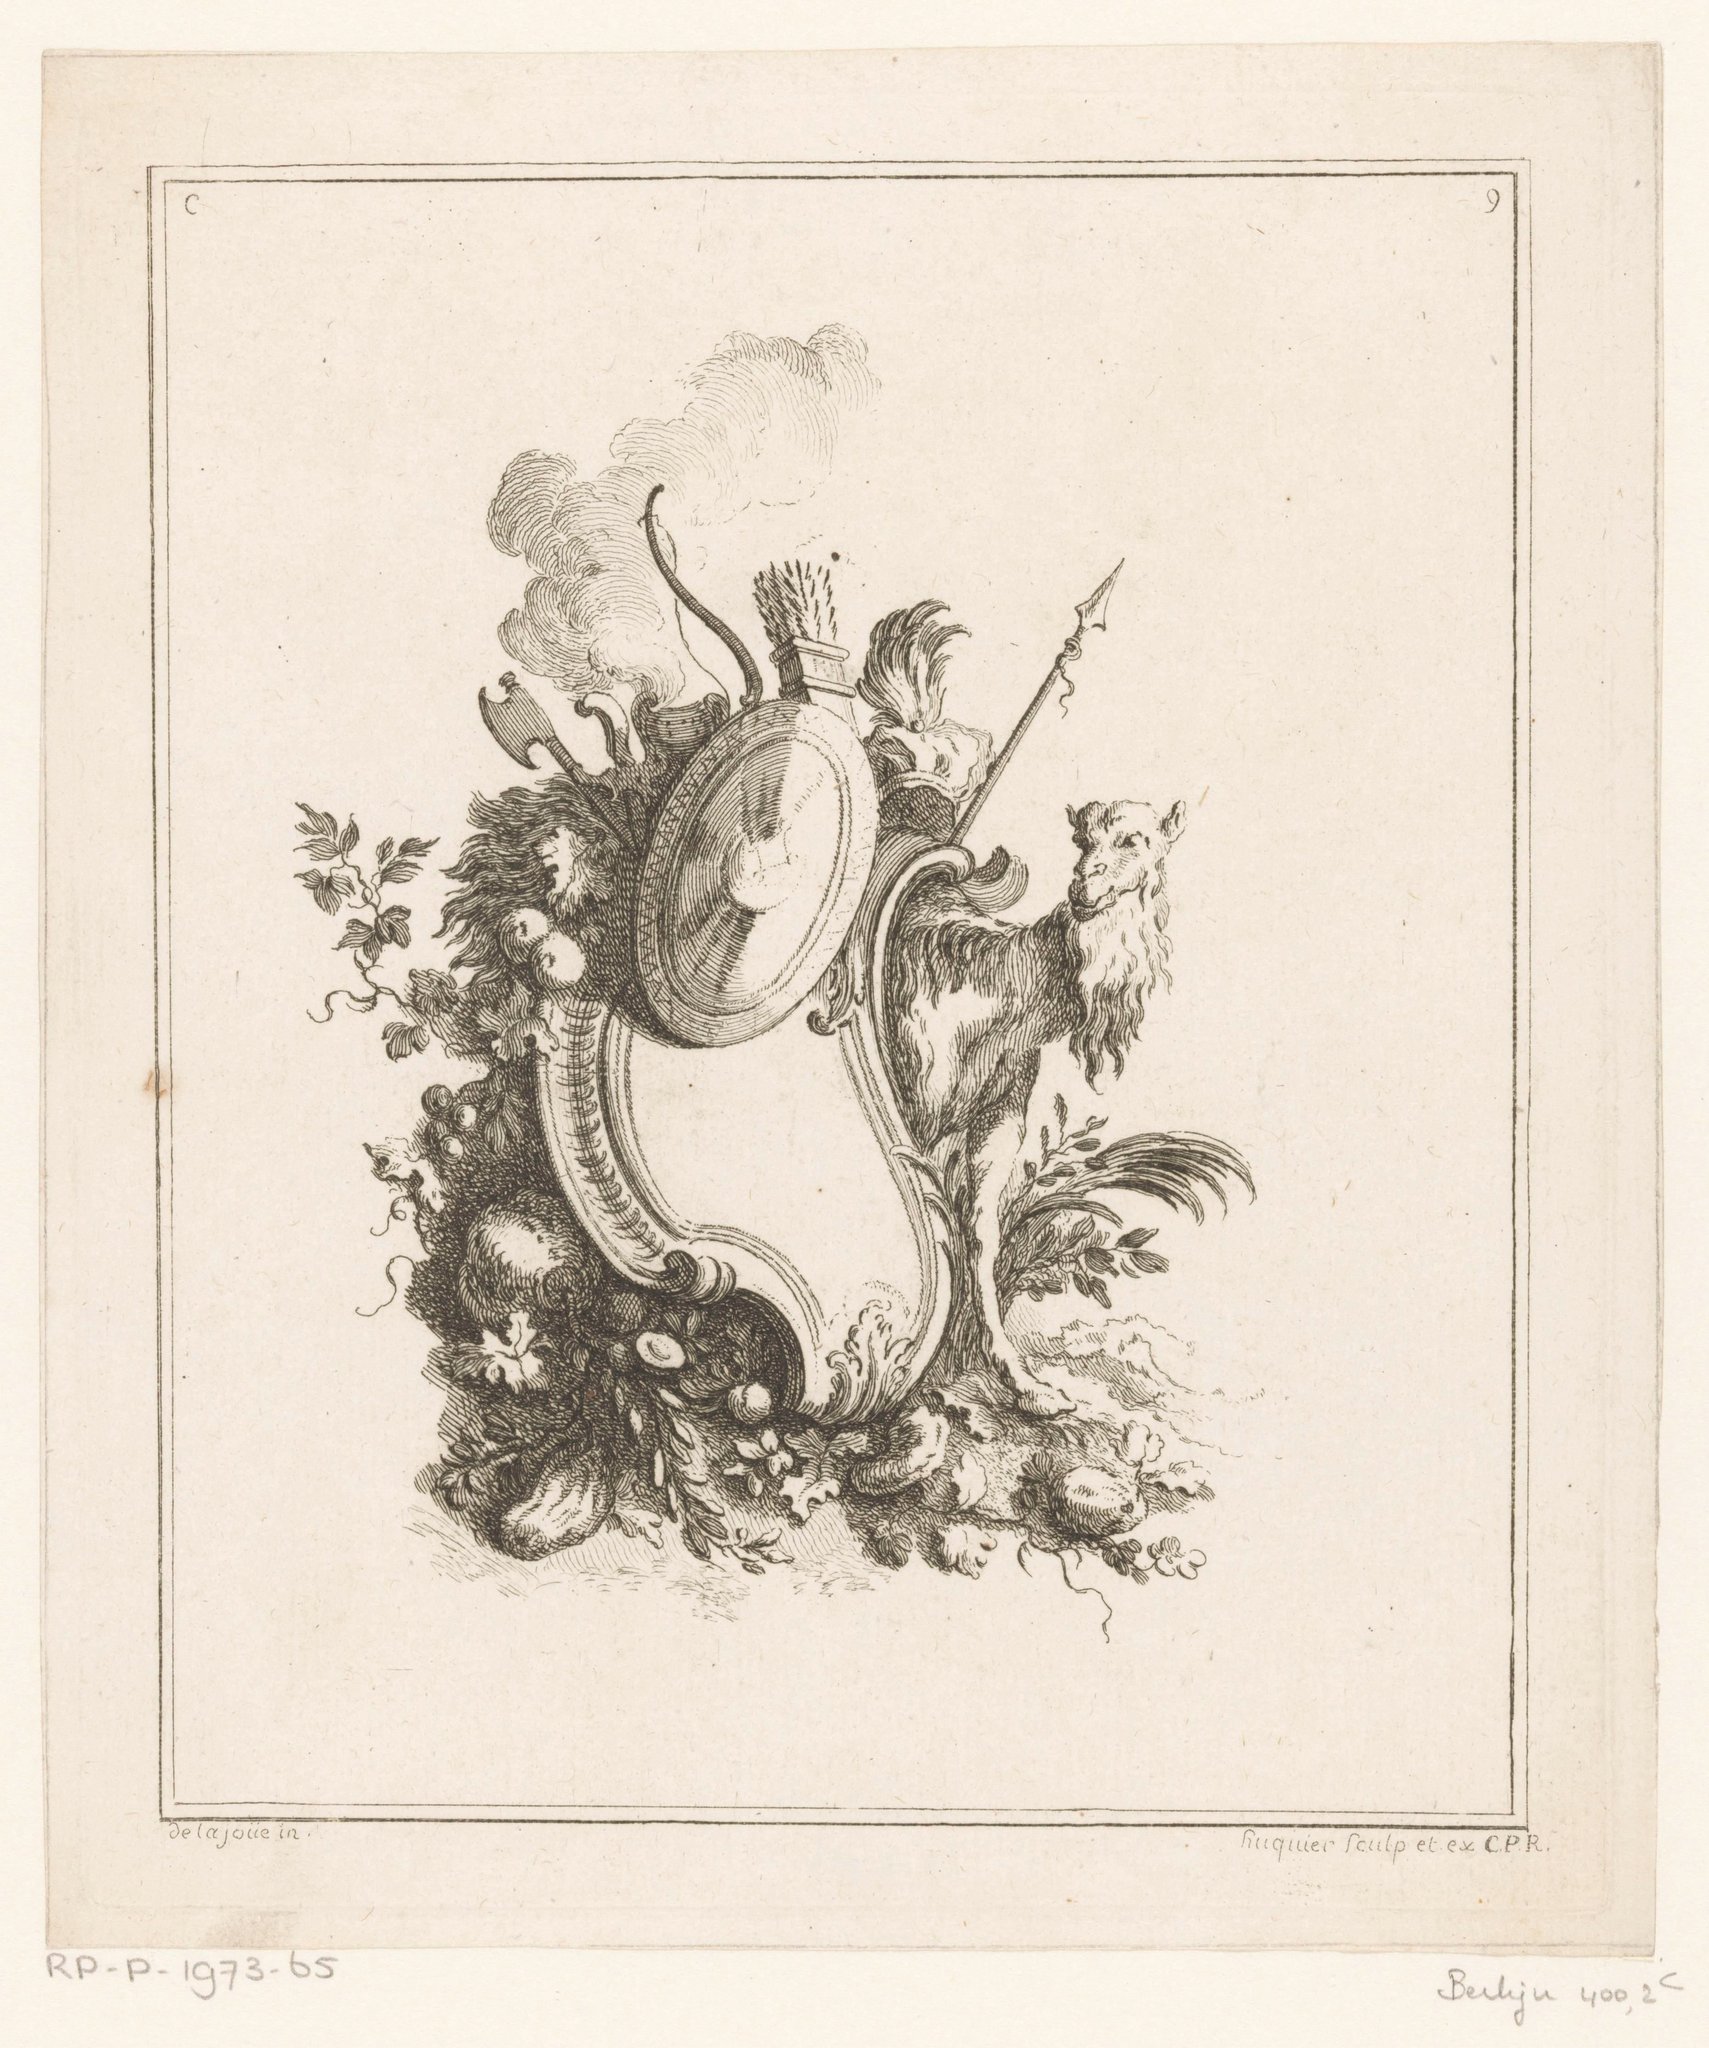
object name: ornament print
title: Cartouche met kameel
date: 1705-1761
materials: paper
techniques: etching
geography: paris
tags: hoofed animals: camel, ornament ~ cartouche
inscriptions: collector's mark: Lugt 2760, collector's mark: Lugt 2228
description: Rechts van een cartouche staat een kameel of dromedaris. Bovenop het cartouche liggen enkele wapens en een schild, links daarvan fruit.